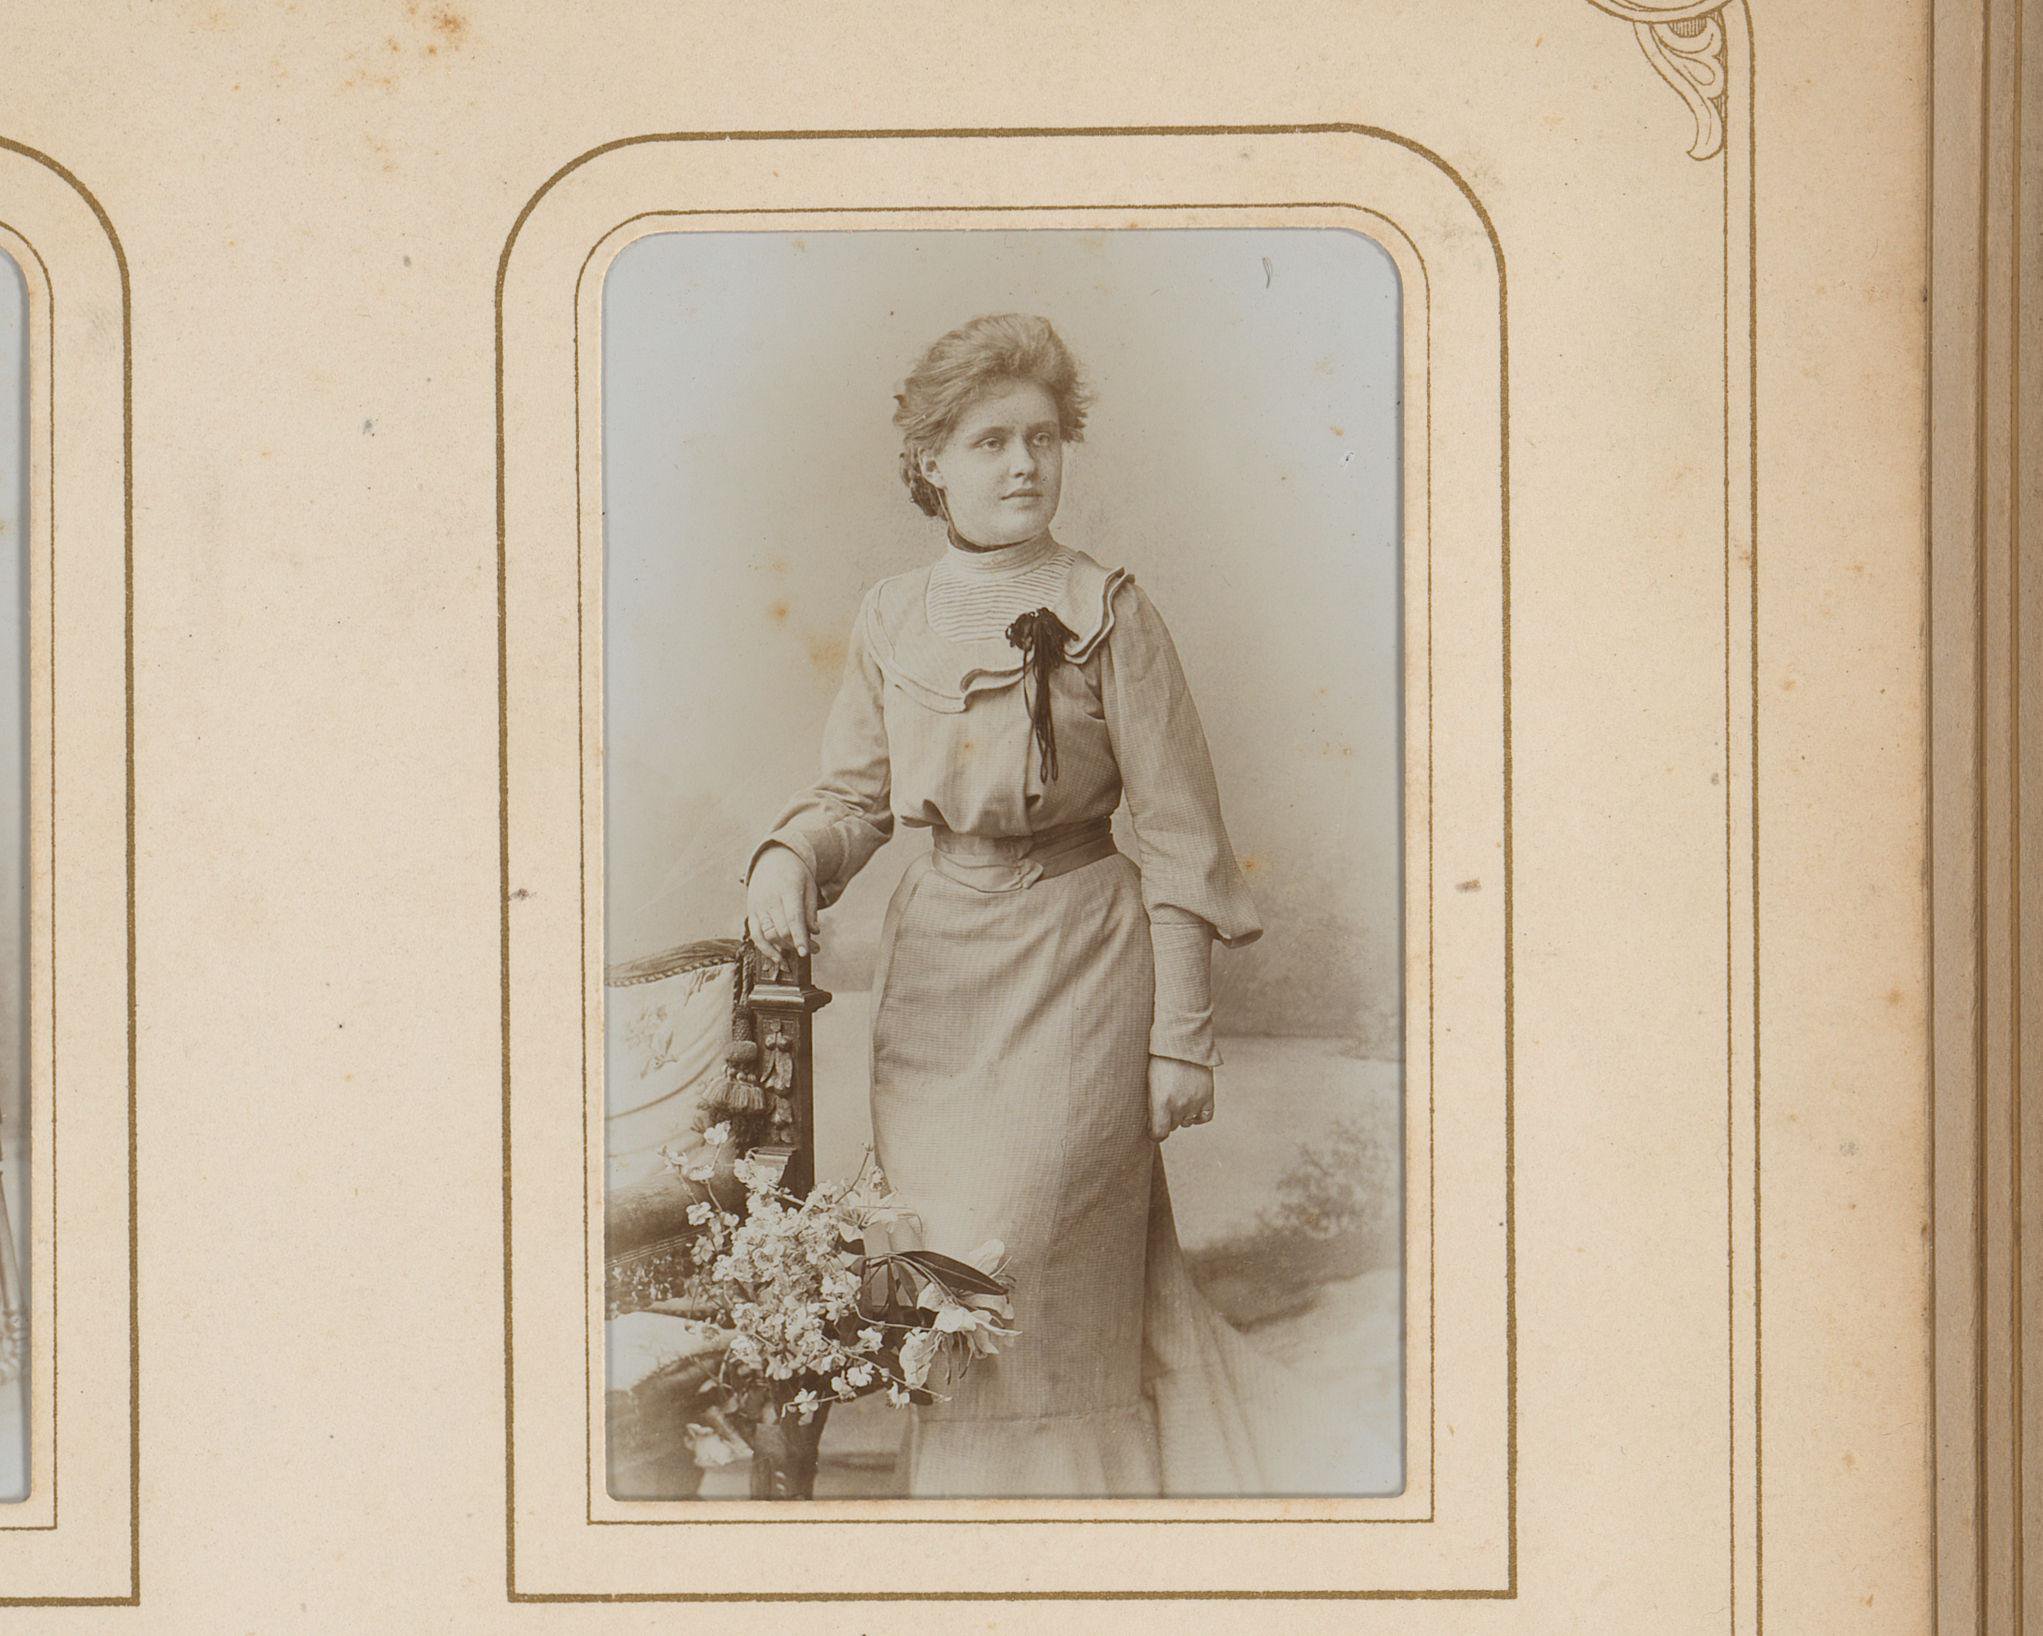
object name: photograph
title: Portret van een staande vrouw bij een stoel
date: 1880-1940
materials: cardboard, photographic support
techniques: collodion silver print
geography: charlottenburg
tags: historical persons - bb - woman, chair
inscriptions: inscription: ‘Waaren-/ Kaufhaus/ Jacob Gebrüder/ Nachfl./ Wilmersdorfer-Str. 56/ Charlottenburg./ Visit.v.M. 1,89 pr.Dtz.an - Cabinet v.M. 4,80 pr.Dtz.an./ Postkarten M 1,20 pr.Dtz./ für 1 Person./ Gruppen und Vergrösserungen./ Aufnahmen finden täglich von 9-6 Uhr statt./ Sonntags von 10 Uhr ab geöffnet.’, number: ‘98258’